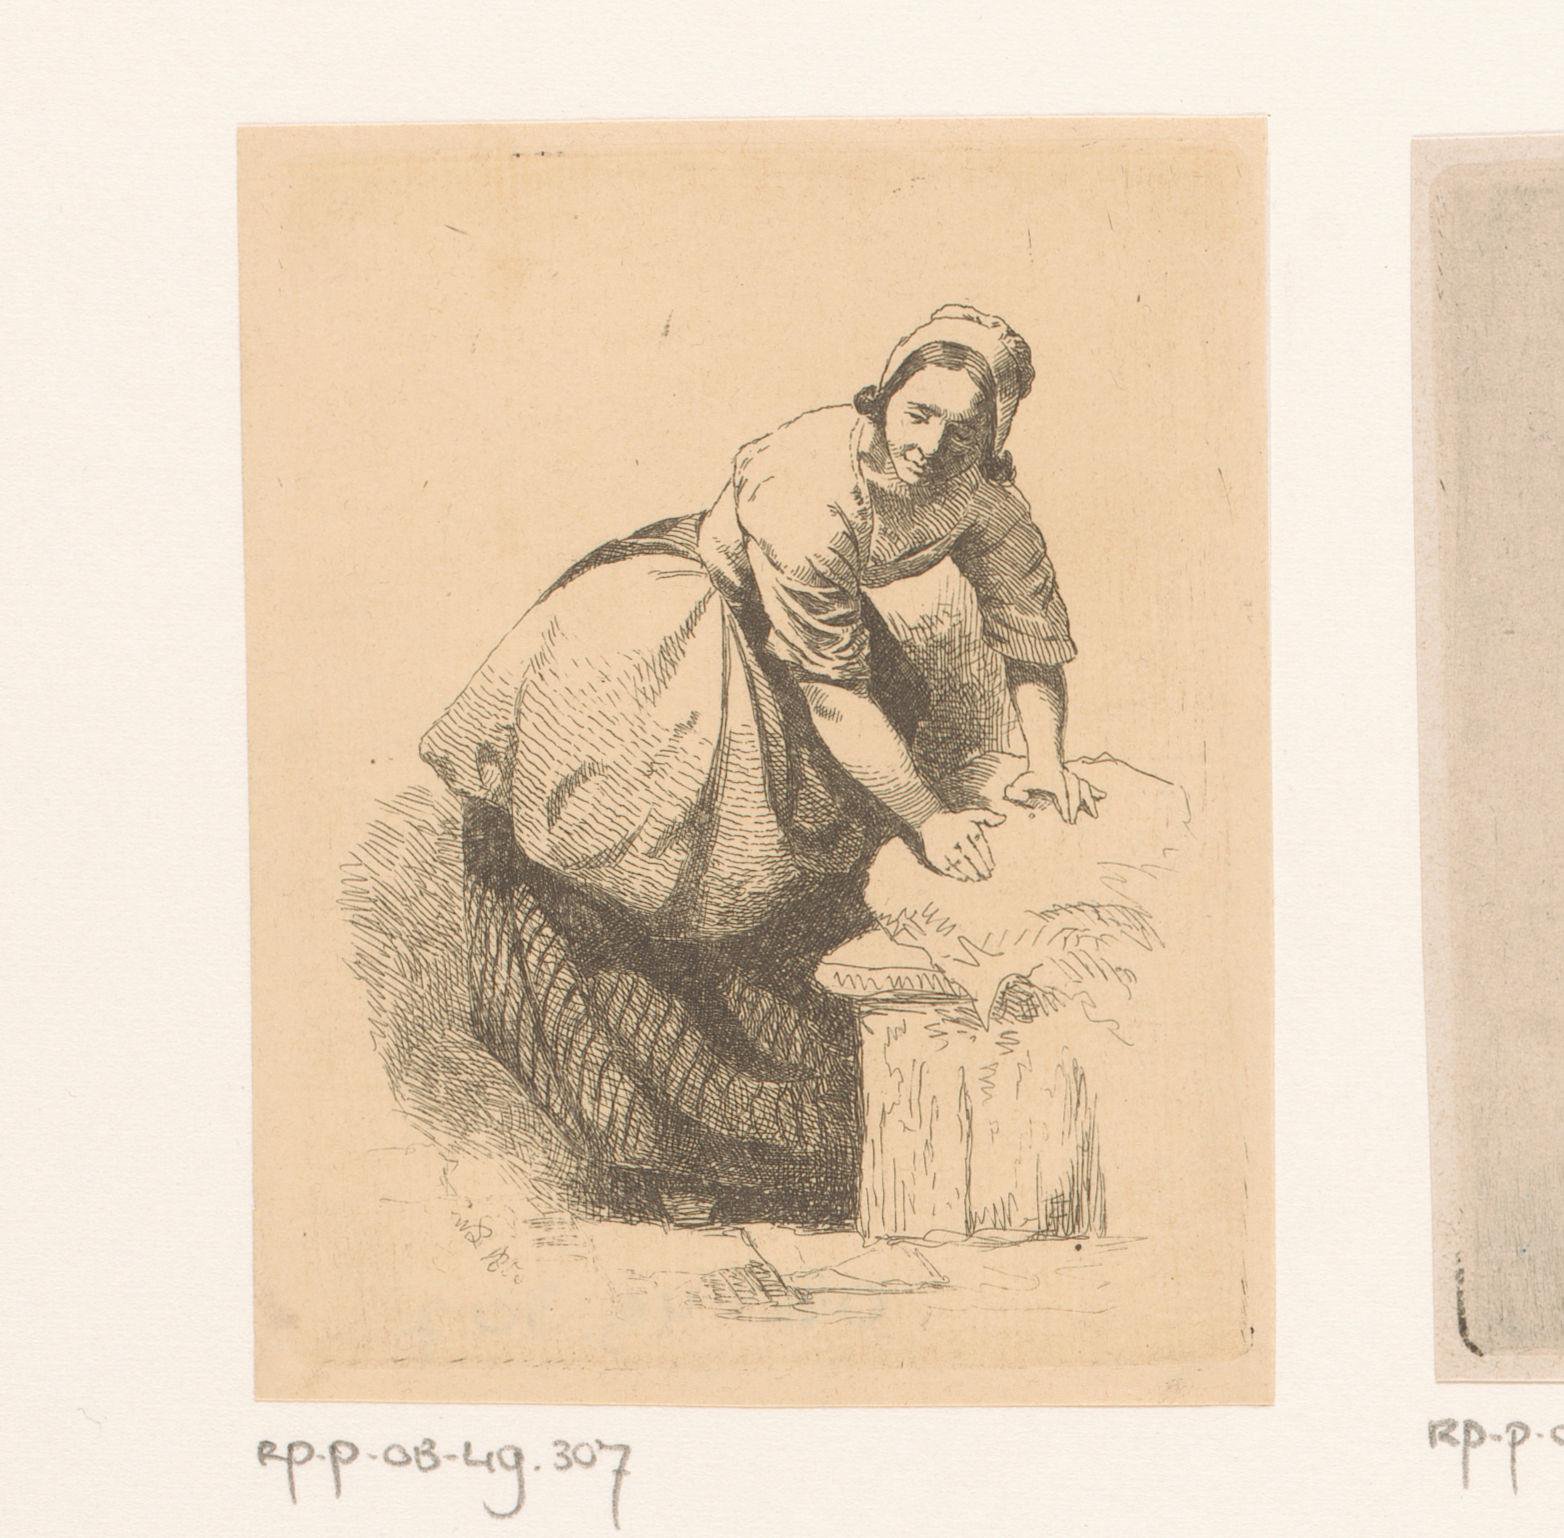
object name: print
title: Vooroverbuigende vrouw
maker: willem linnig (i)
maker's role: print maker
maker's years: 1819-1885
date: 1850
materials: paper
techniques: etching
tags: adult woman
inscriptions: collector's mark: Lugt 2228